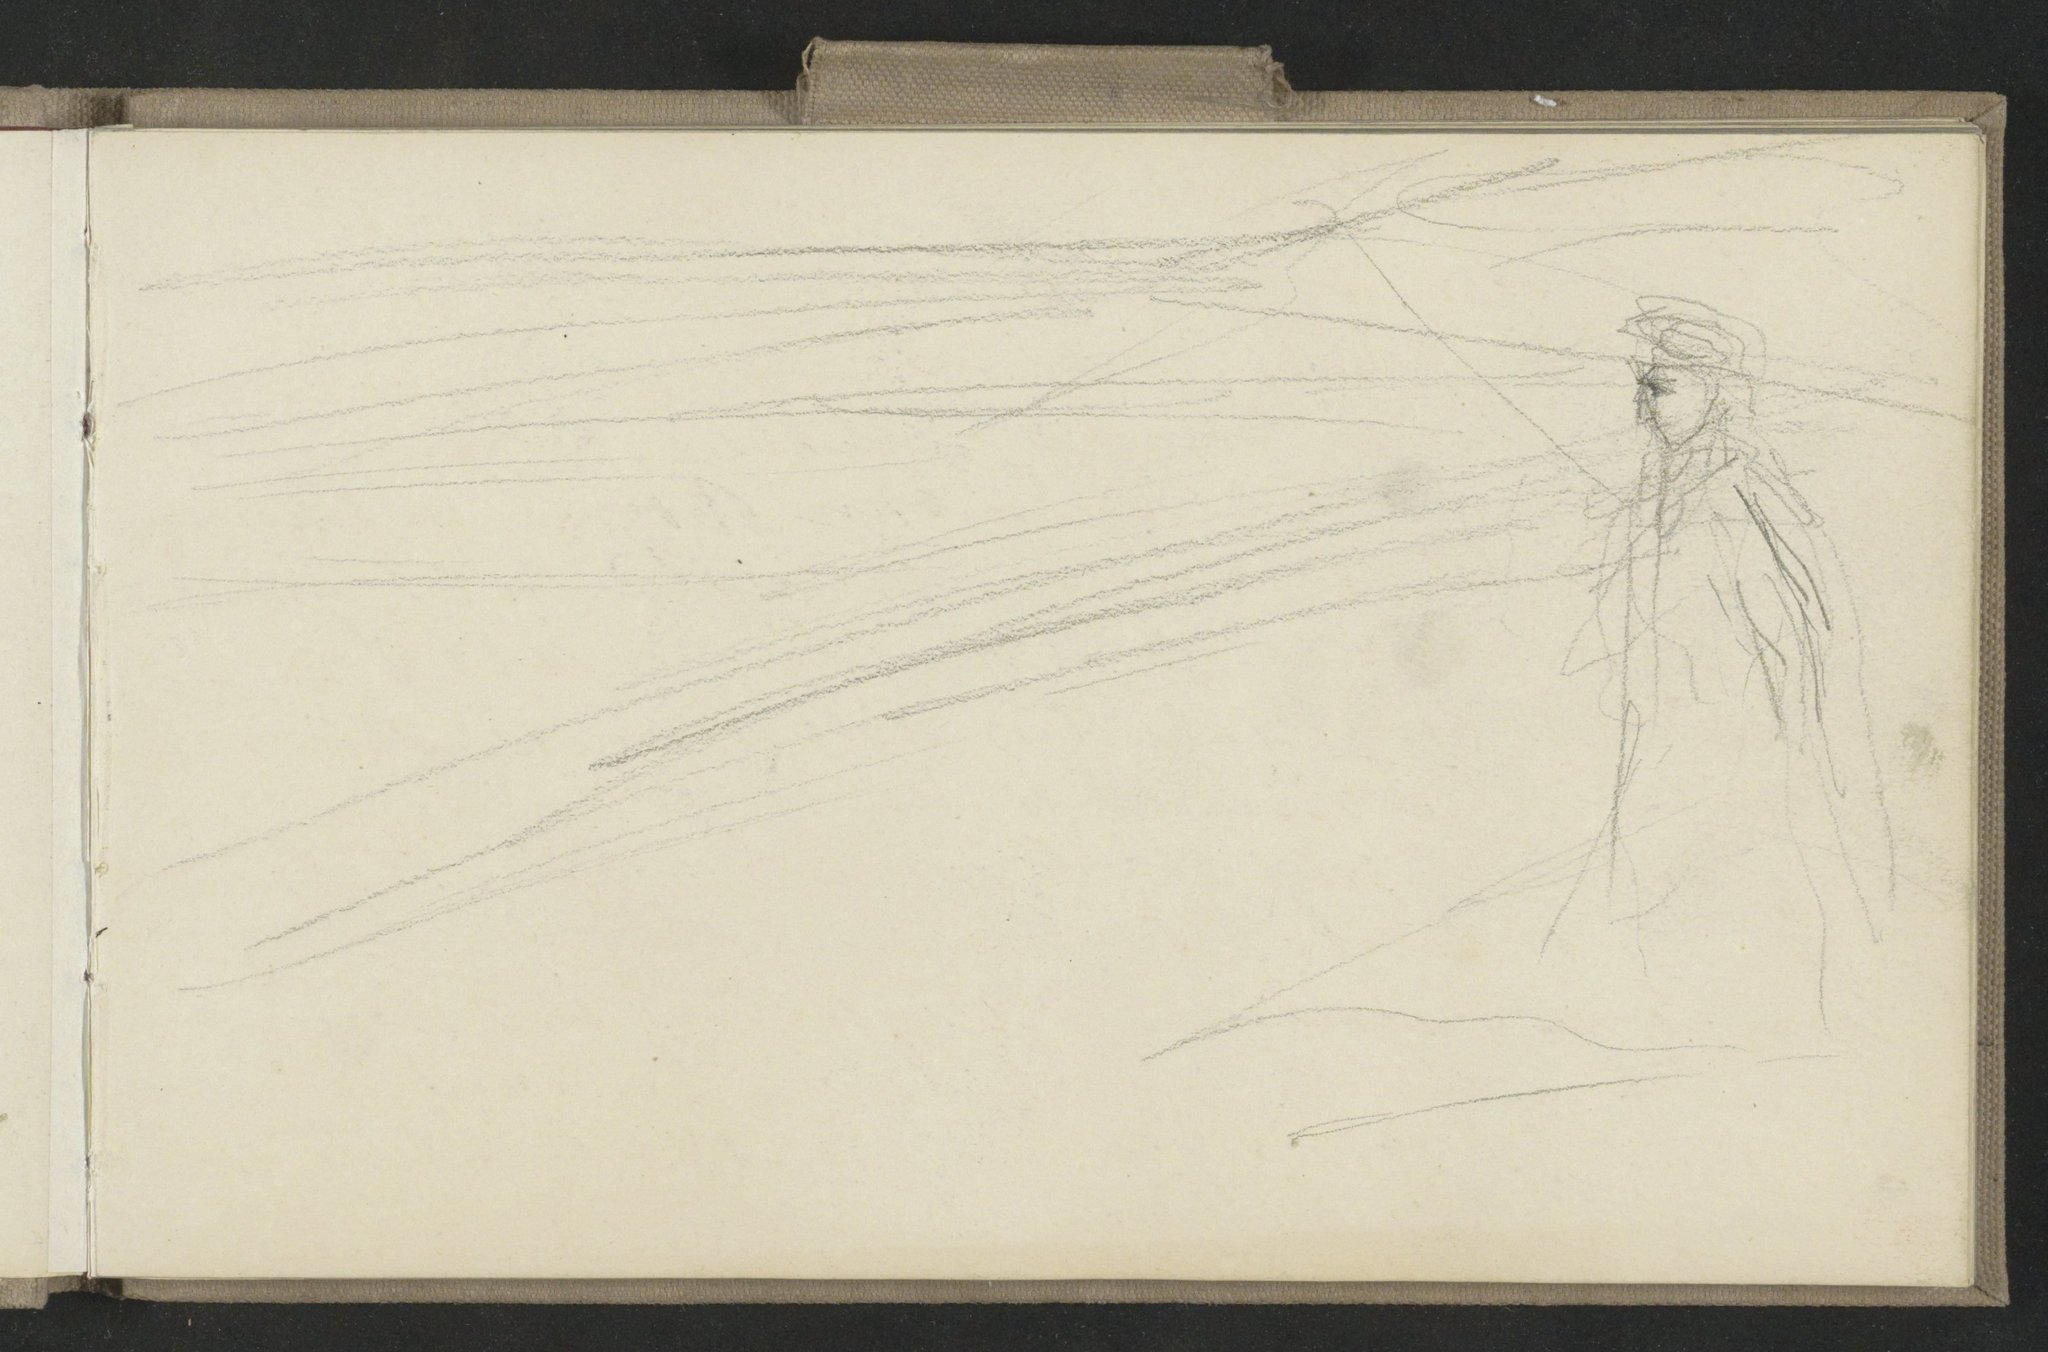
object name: sketchbook leaf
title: Figuur in een landschap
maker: jozef israëls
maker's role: draughtsman, painter, print maker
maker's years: 1824-1911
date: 1834-1911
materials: paper, pencil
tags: landscapes (+ landscape with figures, staffage)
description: Blad 1 recto uit een schetsboek met 26 bladen.